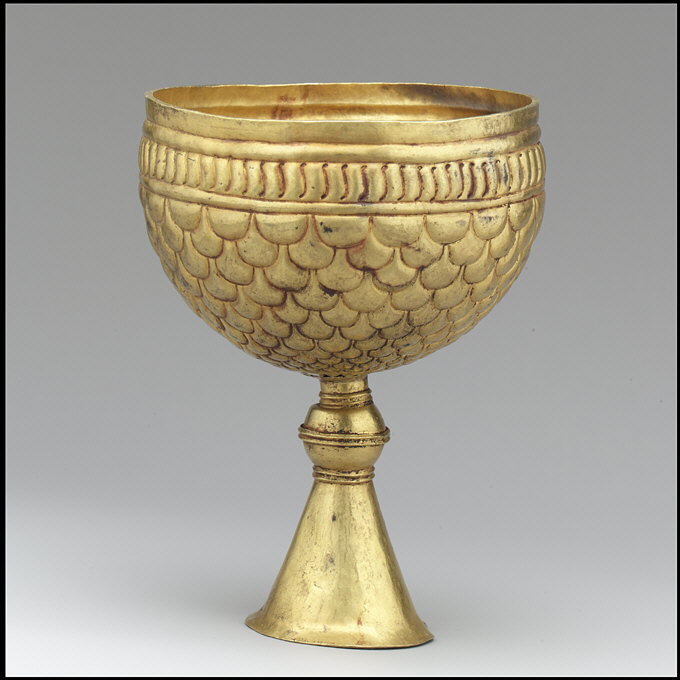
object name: chalice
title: Goblet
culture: avar or byzantine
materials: gold